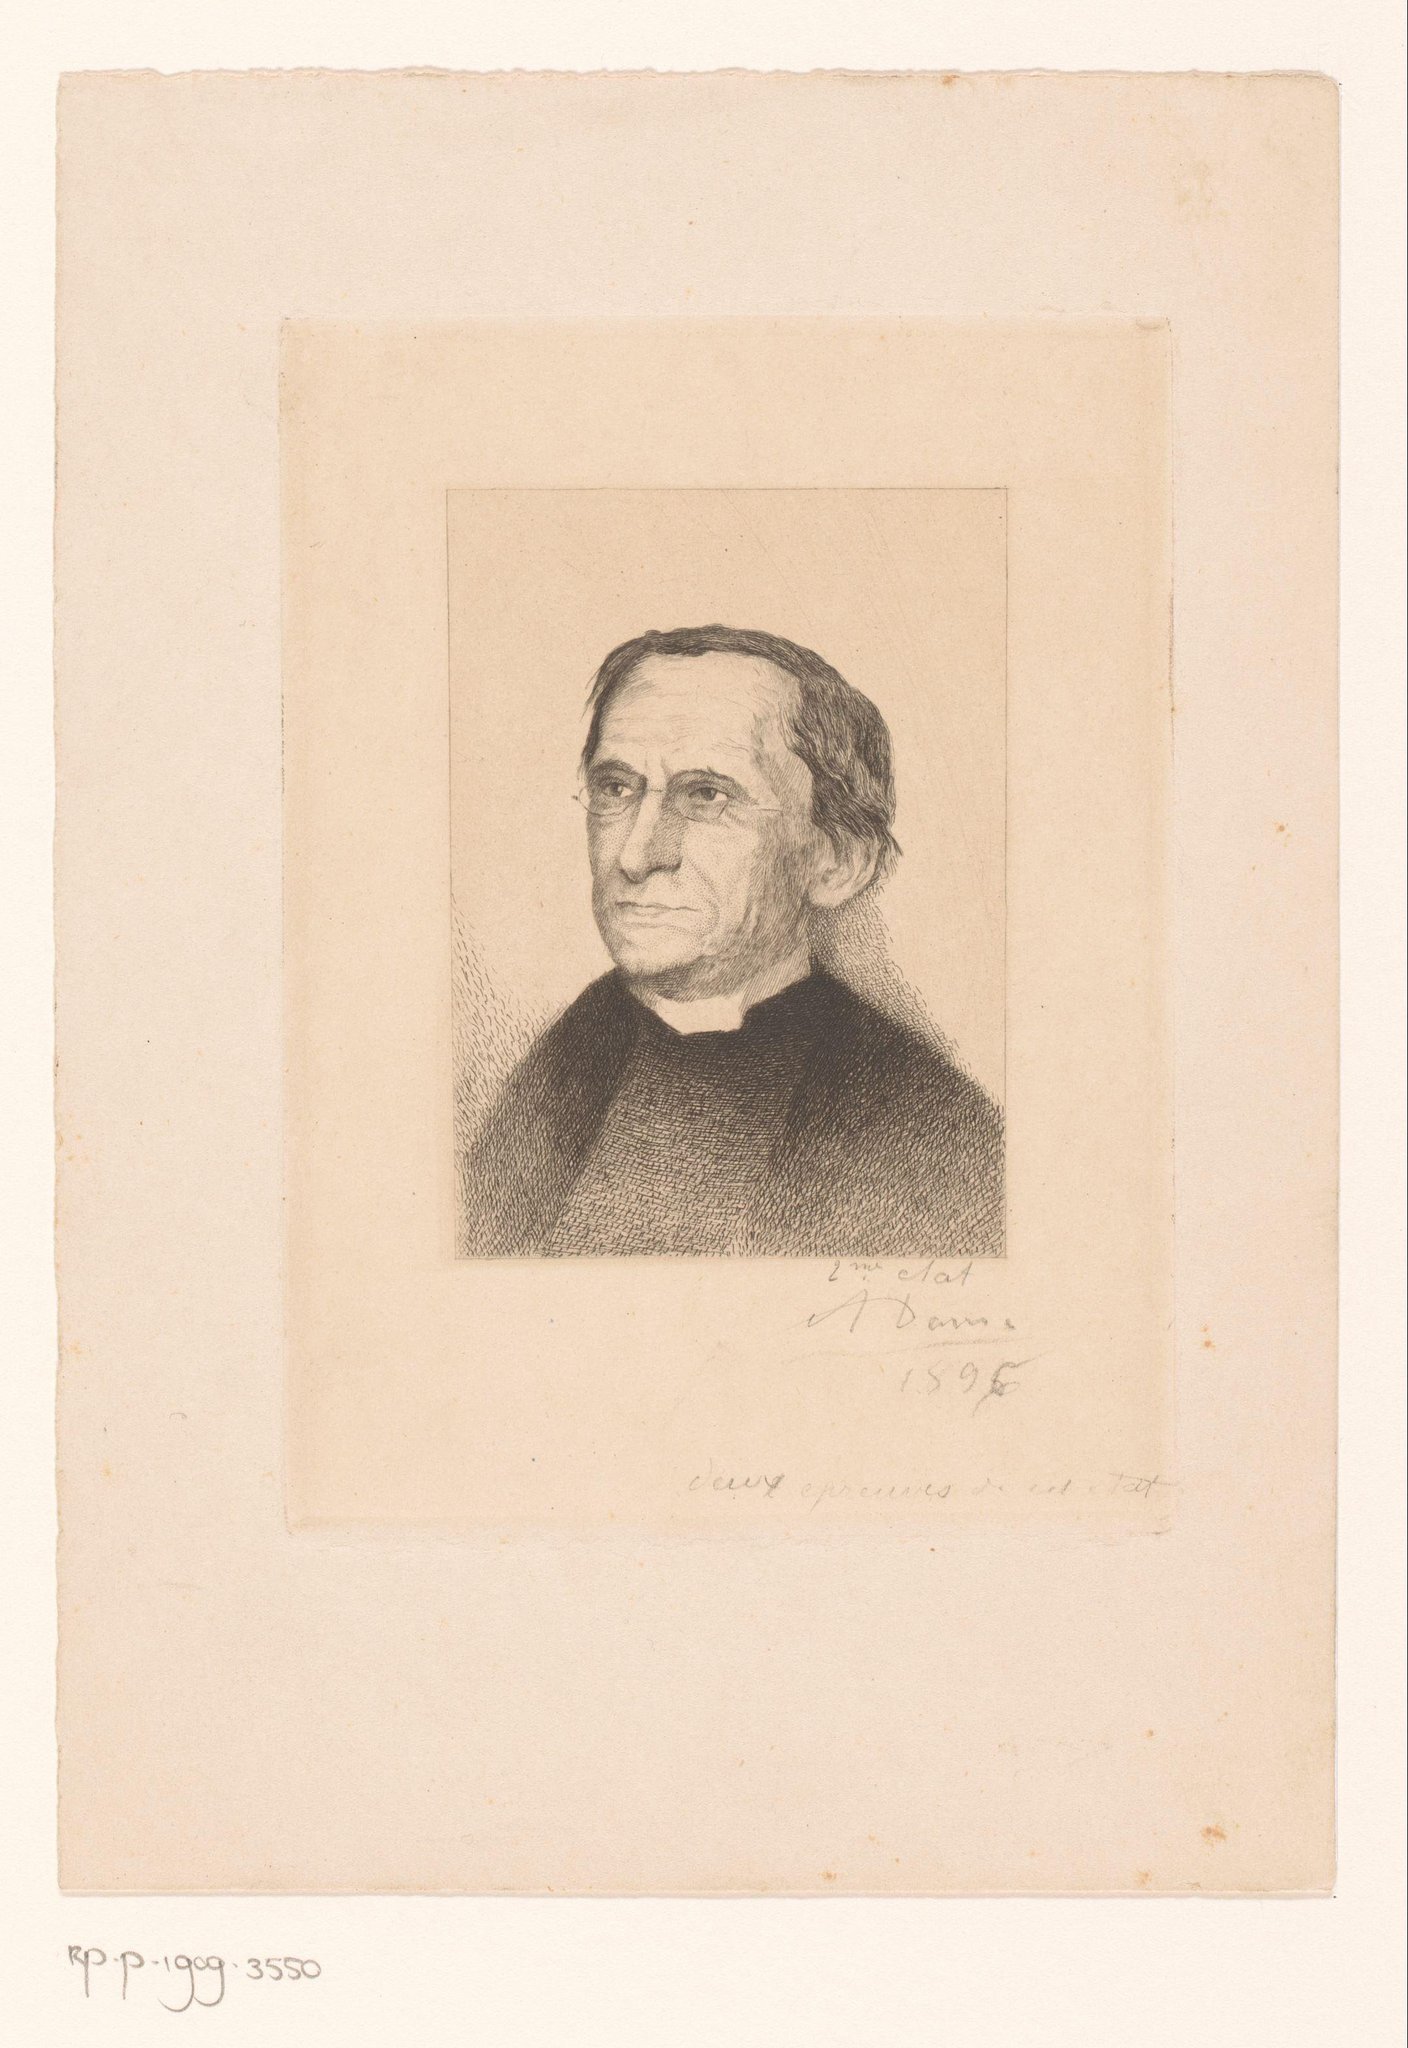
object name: print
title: Portret van Charles de Harlez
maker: auguste danse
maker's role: print maker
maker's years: 1829-1929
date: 1895-1896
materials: paper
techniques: etching, intaglio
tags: liège, louvain, priest, historical person (...) - historical person (...) portrayed alone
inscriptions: collector's mark: Lugt 2228, annotation: ‘2me état; deux epreuves de cet etat’